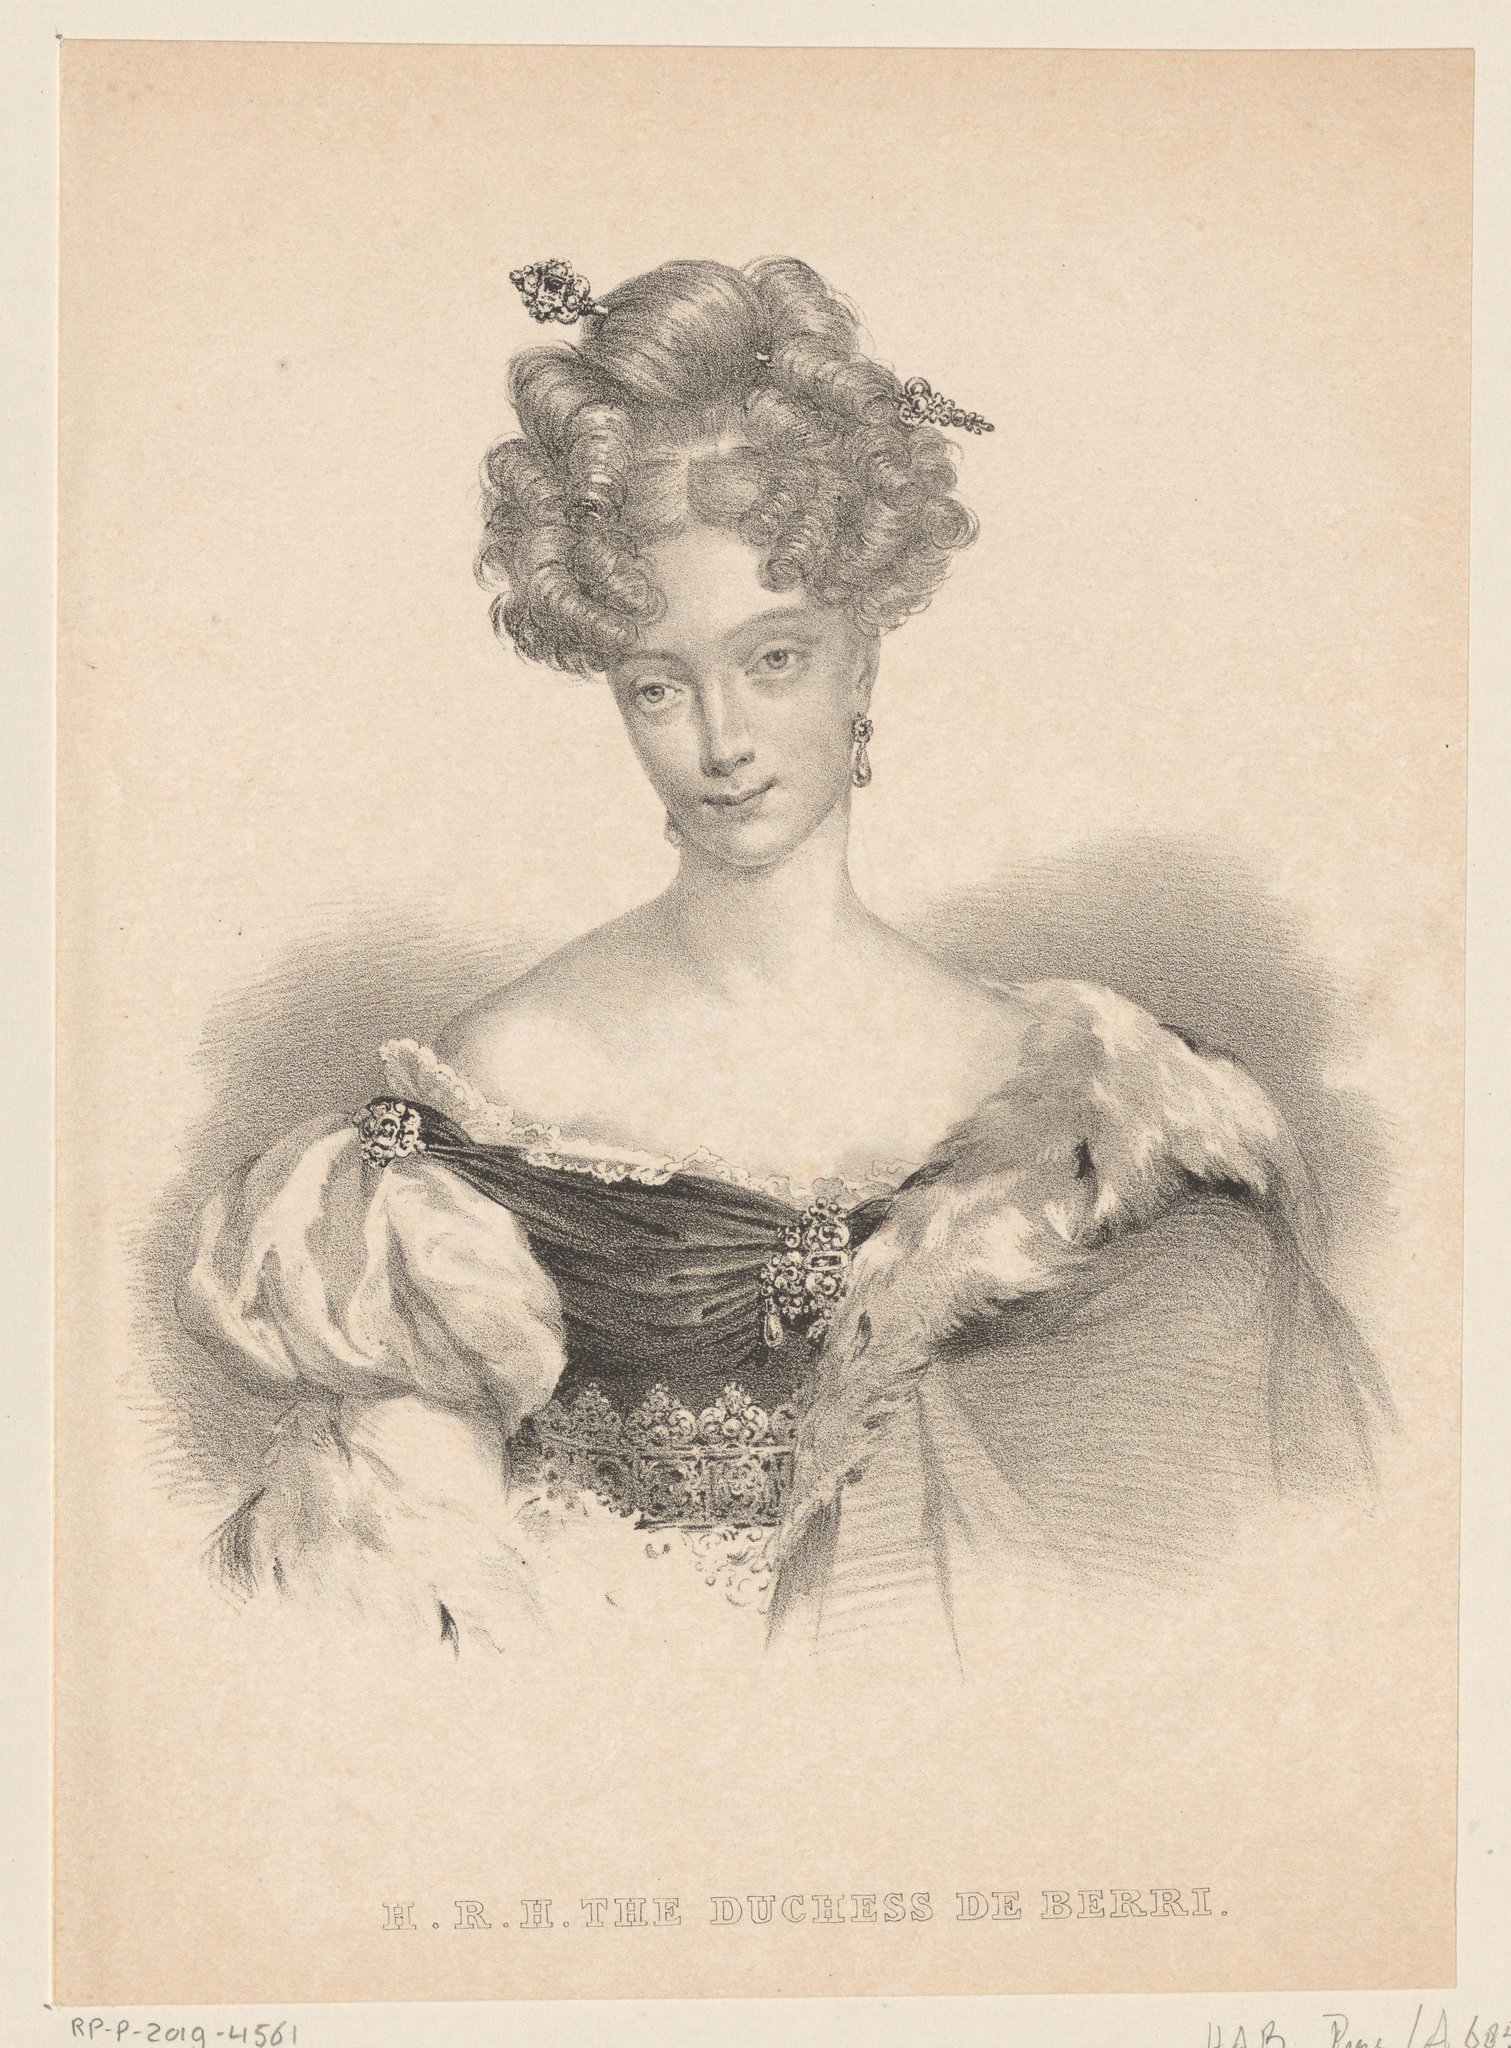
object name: print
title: Portret van Maria Carolina van Bourbon-Sicilië, hertogin van Berry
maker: Anonymous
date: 1816-1849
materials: paper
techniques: lithograph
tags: maria carolina van bourbon-sicilië, historical persons - bb - woman